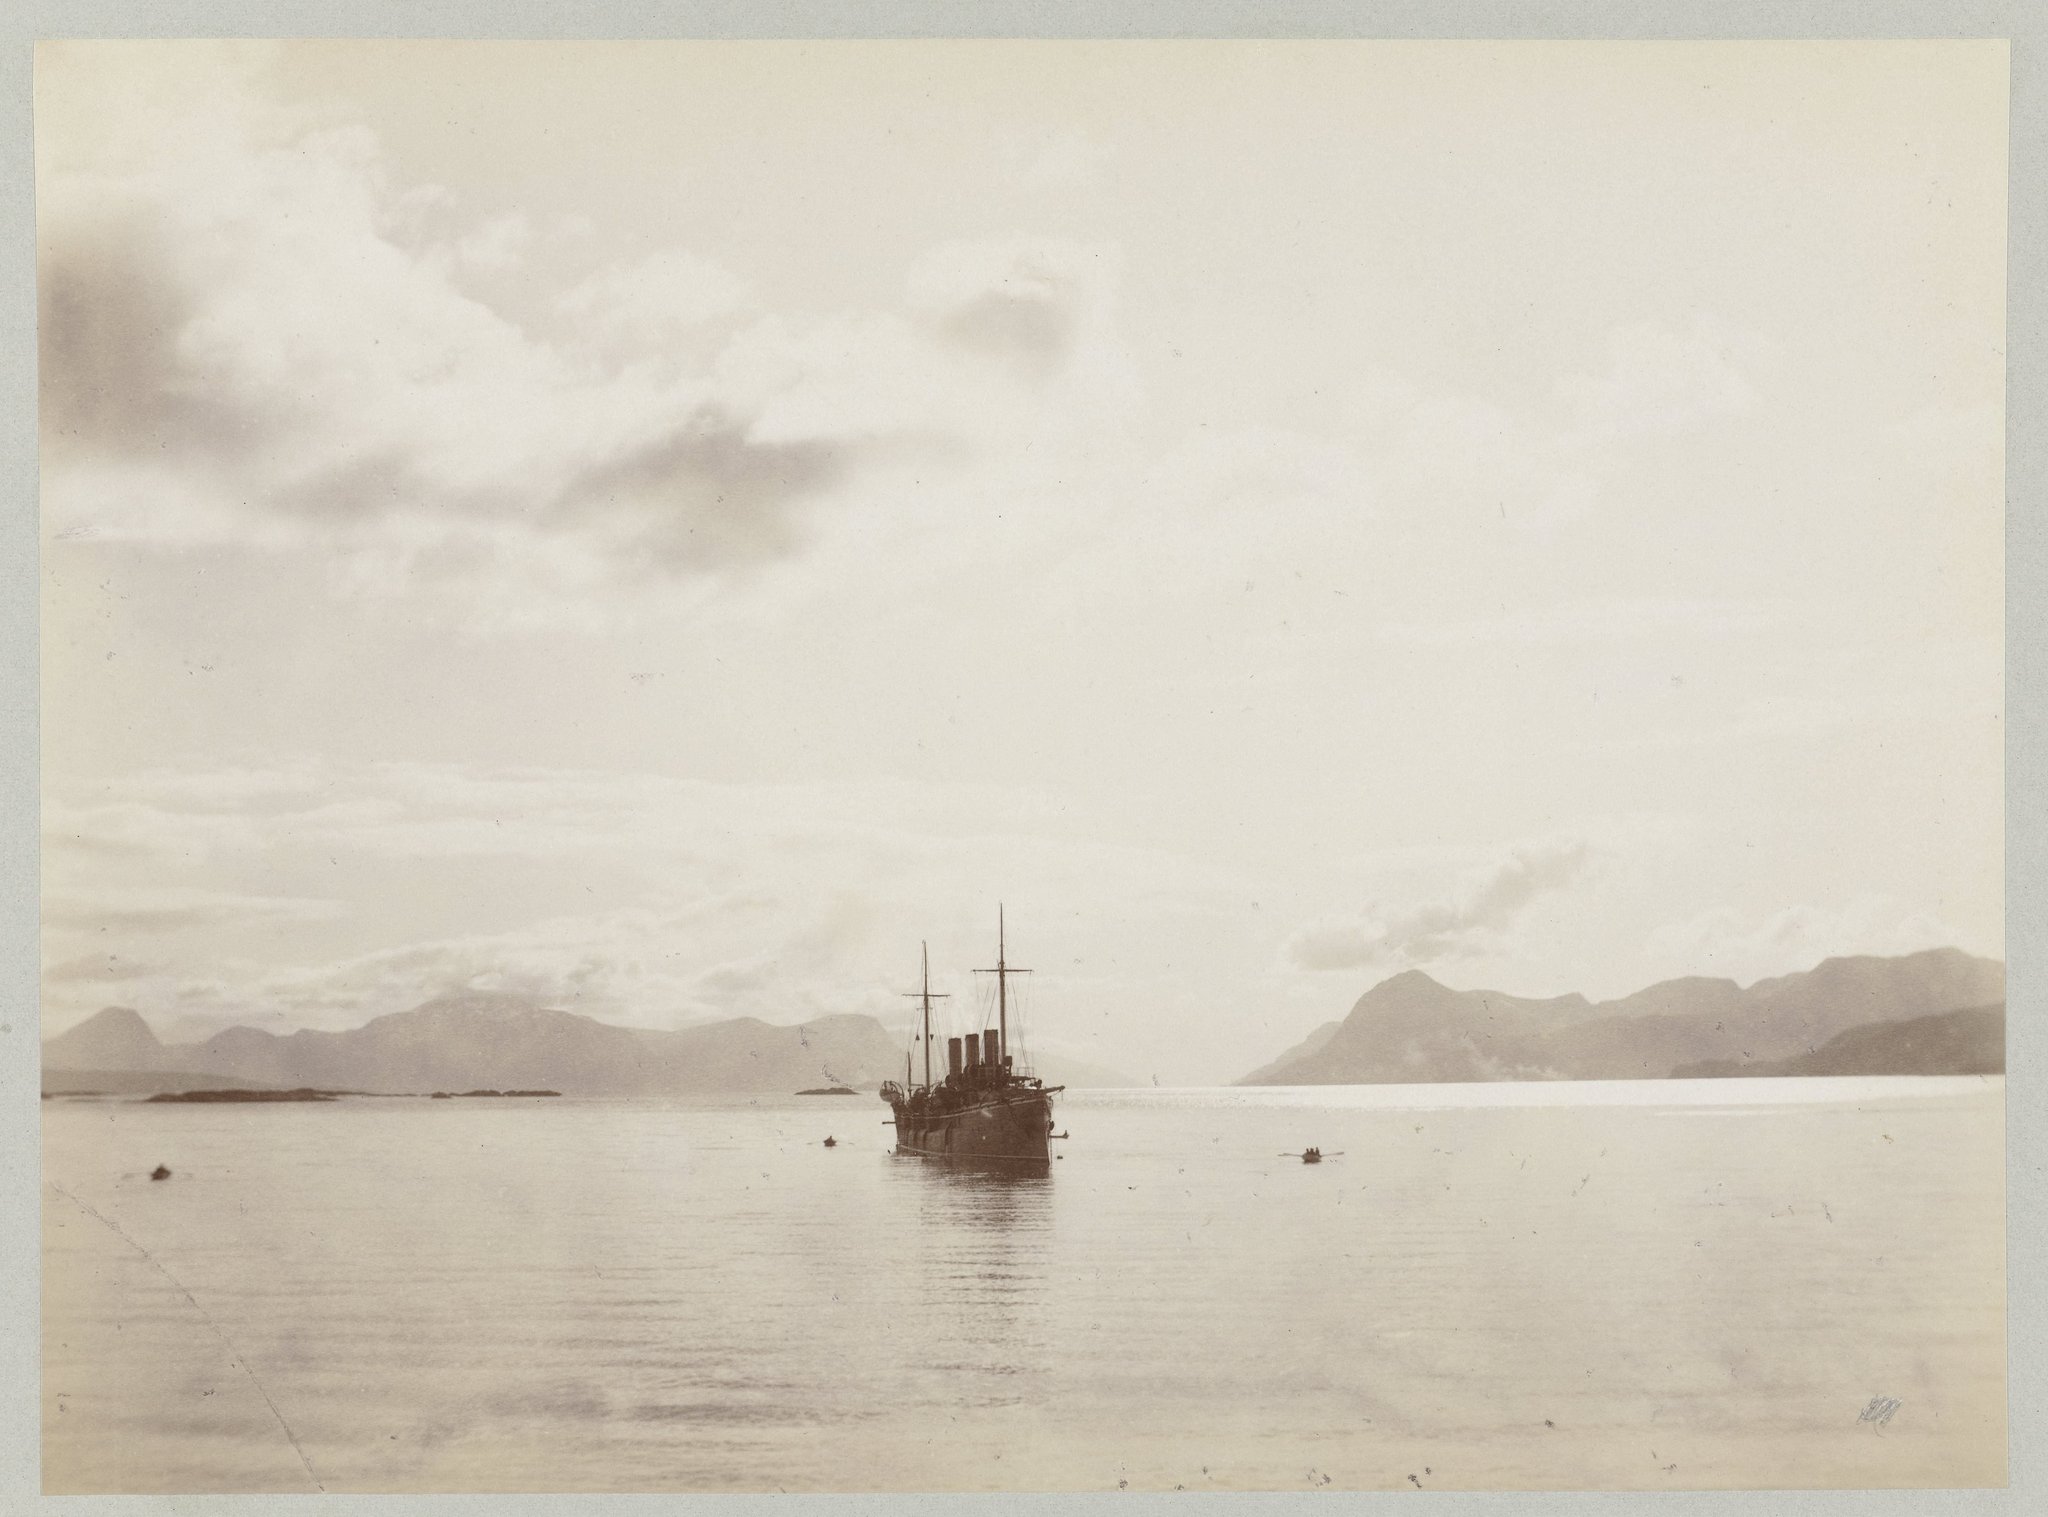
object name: photograph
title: Schip in een baai te Noorwegen met aan nabij een aantal roeiboten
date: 1807-1889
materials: cardboard, paper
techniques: albumen print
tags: wilhelm ii (keizer van duitsland), norway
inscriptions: number: ‘96’, number: ‘22’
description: De afdruk van de foto is rond, het papier vierkant